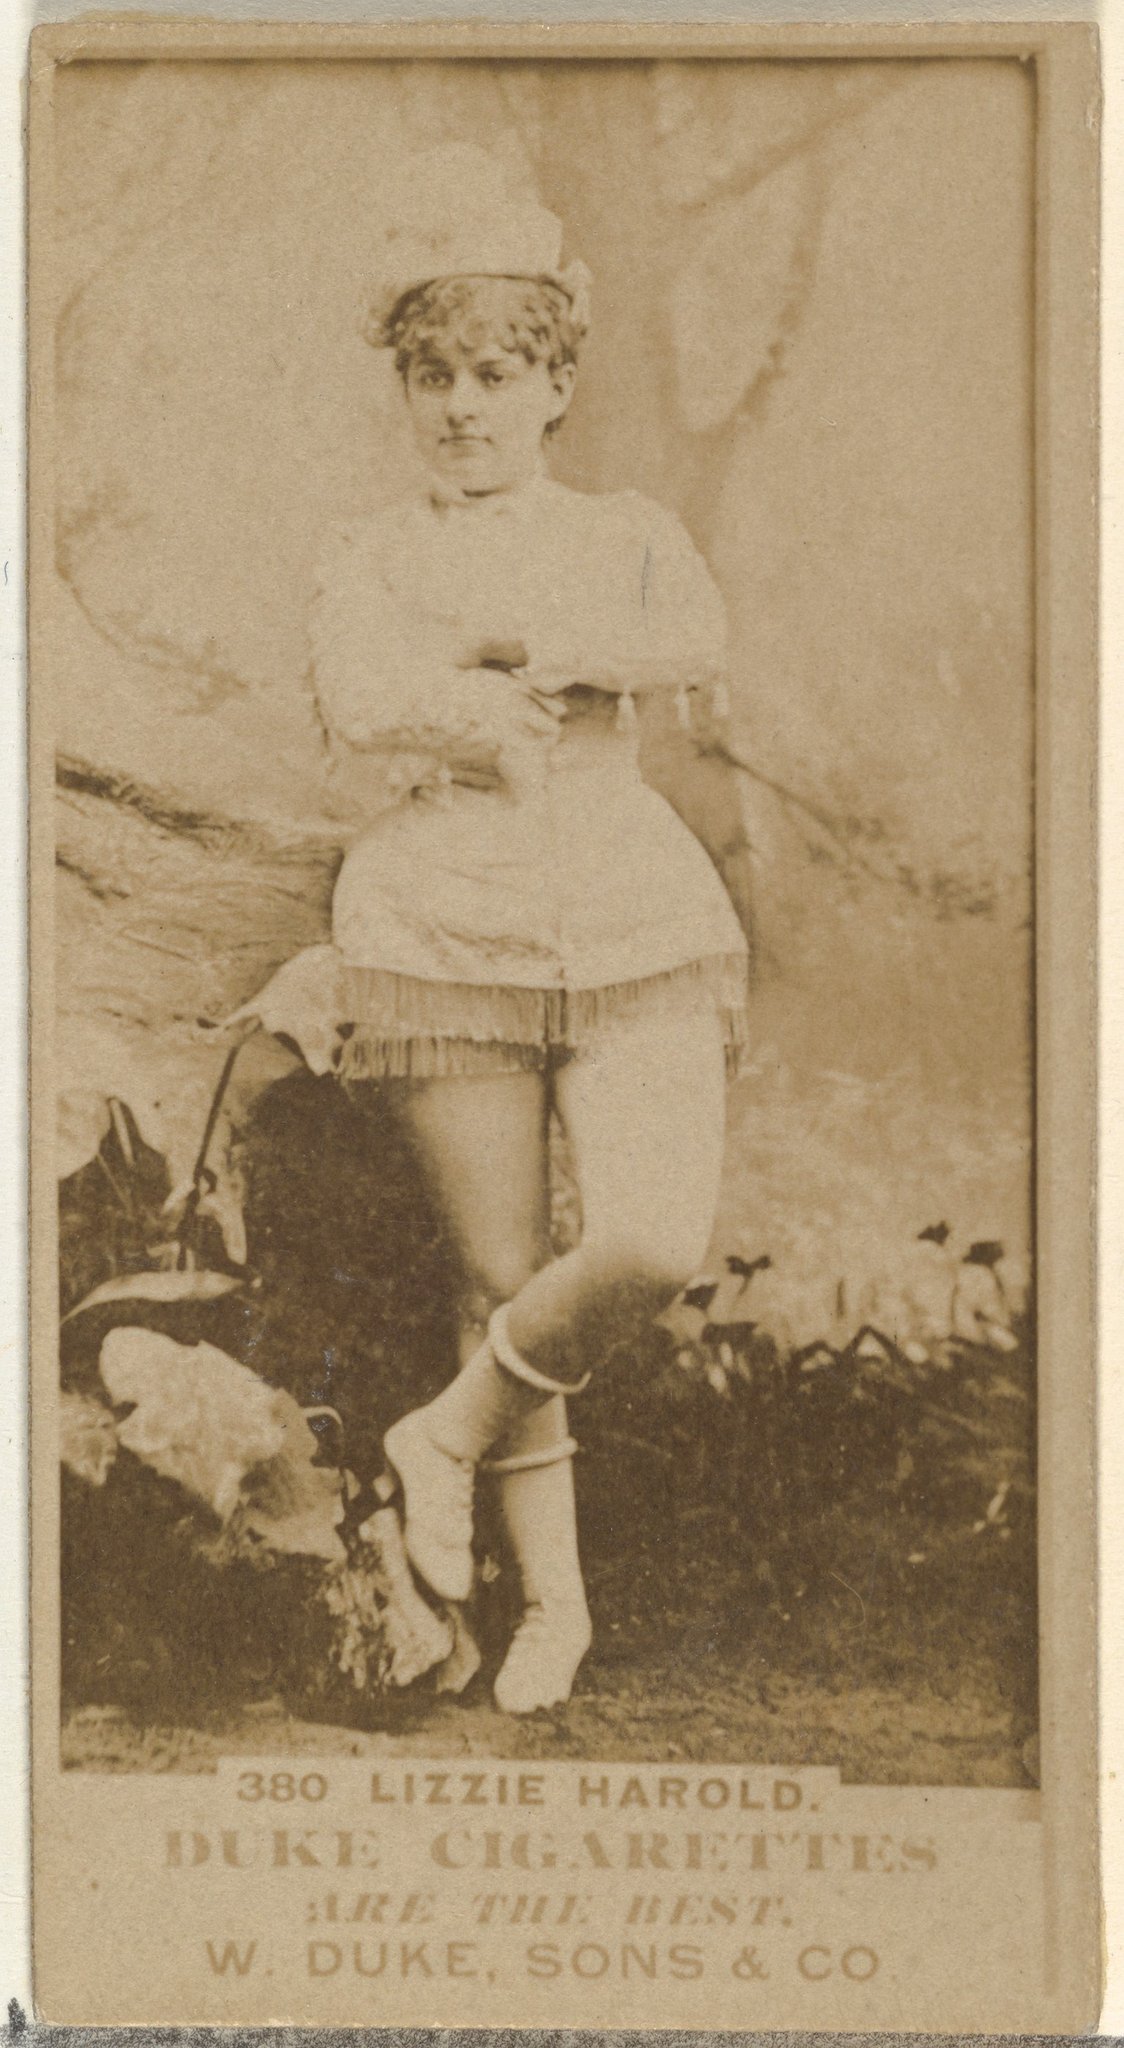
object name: photograph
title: Card Number 380, Lizzie Harold, from the Actors and Actresses series (N145-7) issued by Duke Sons & Co. to promote Duke Cigarettes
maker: w. duke, sons & co.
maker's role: publisher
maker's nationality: american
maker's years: 1870-1920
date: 1880-1889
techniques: albumen silver print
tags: portraits,women,actresses